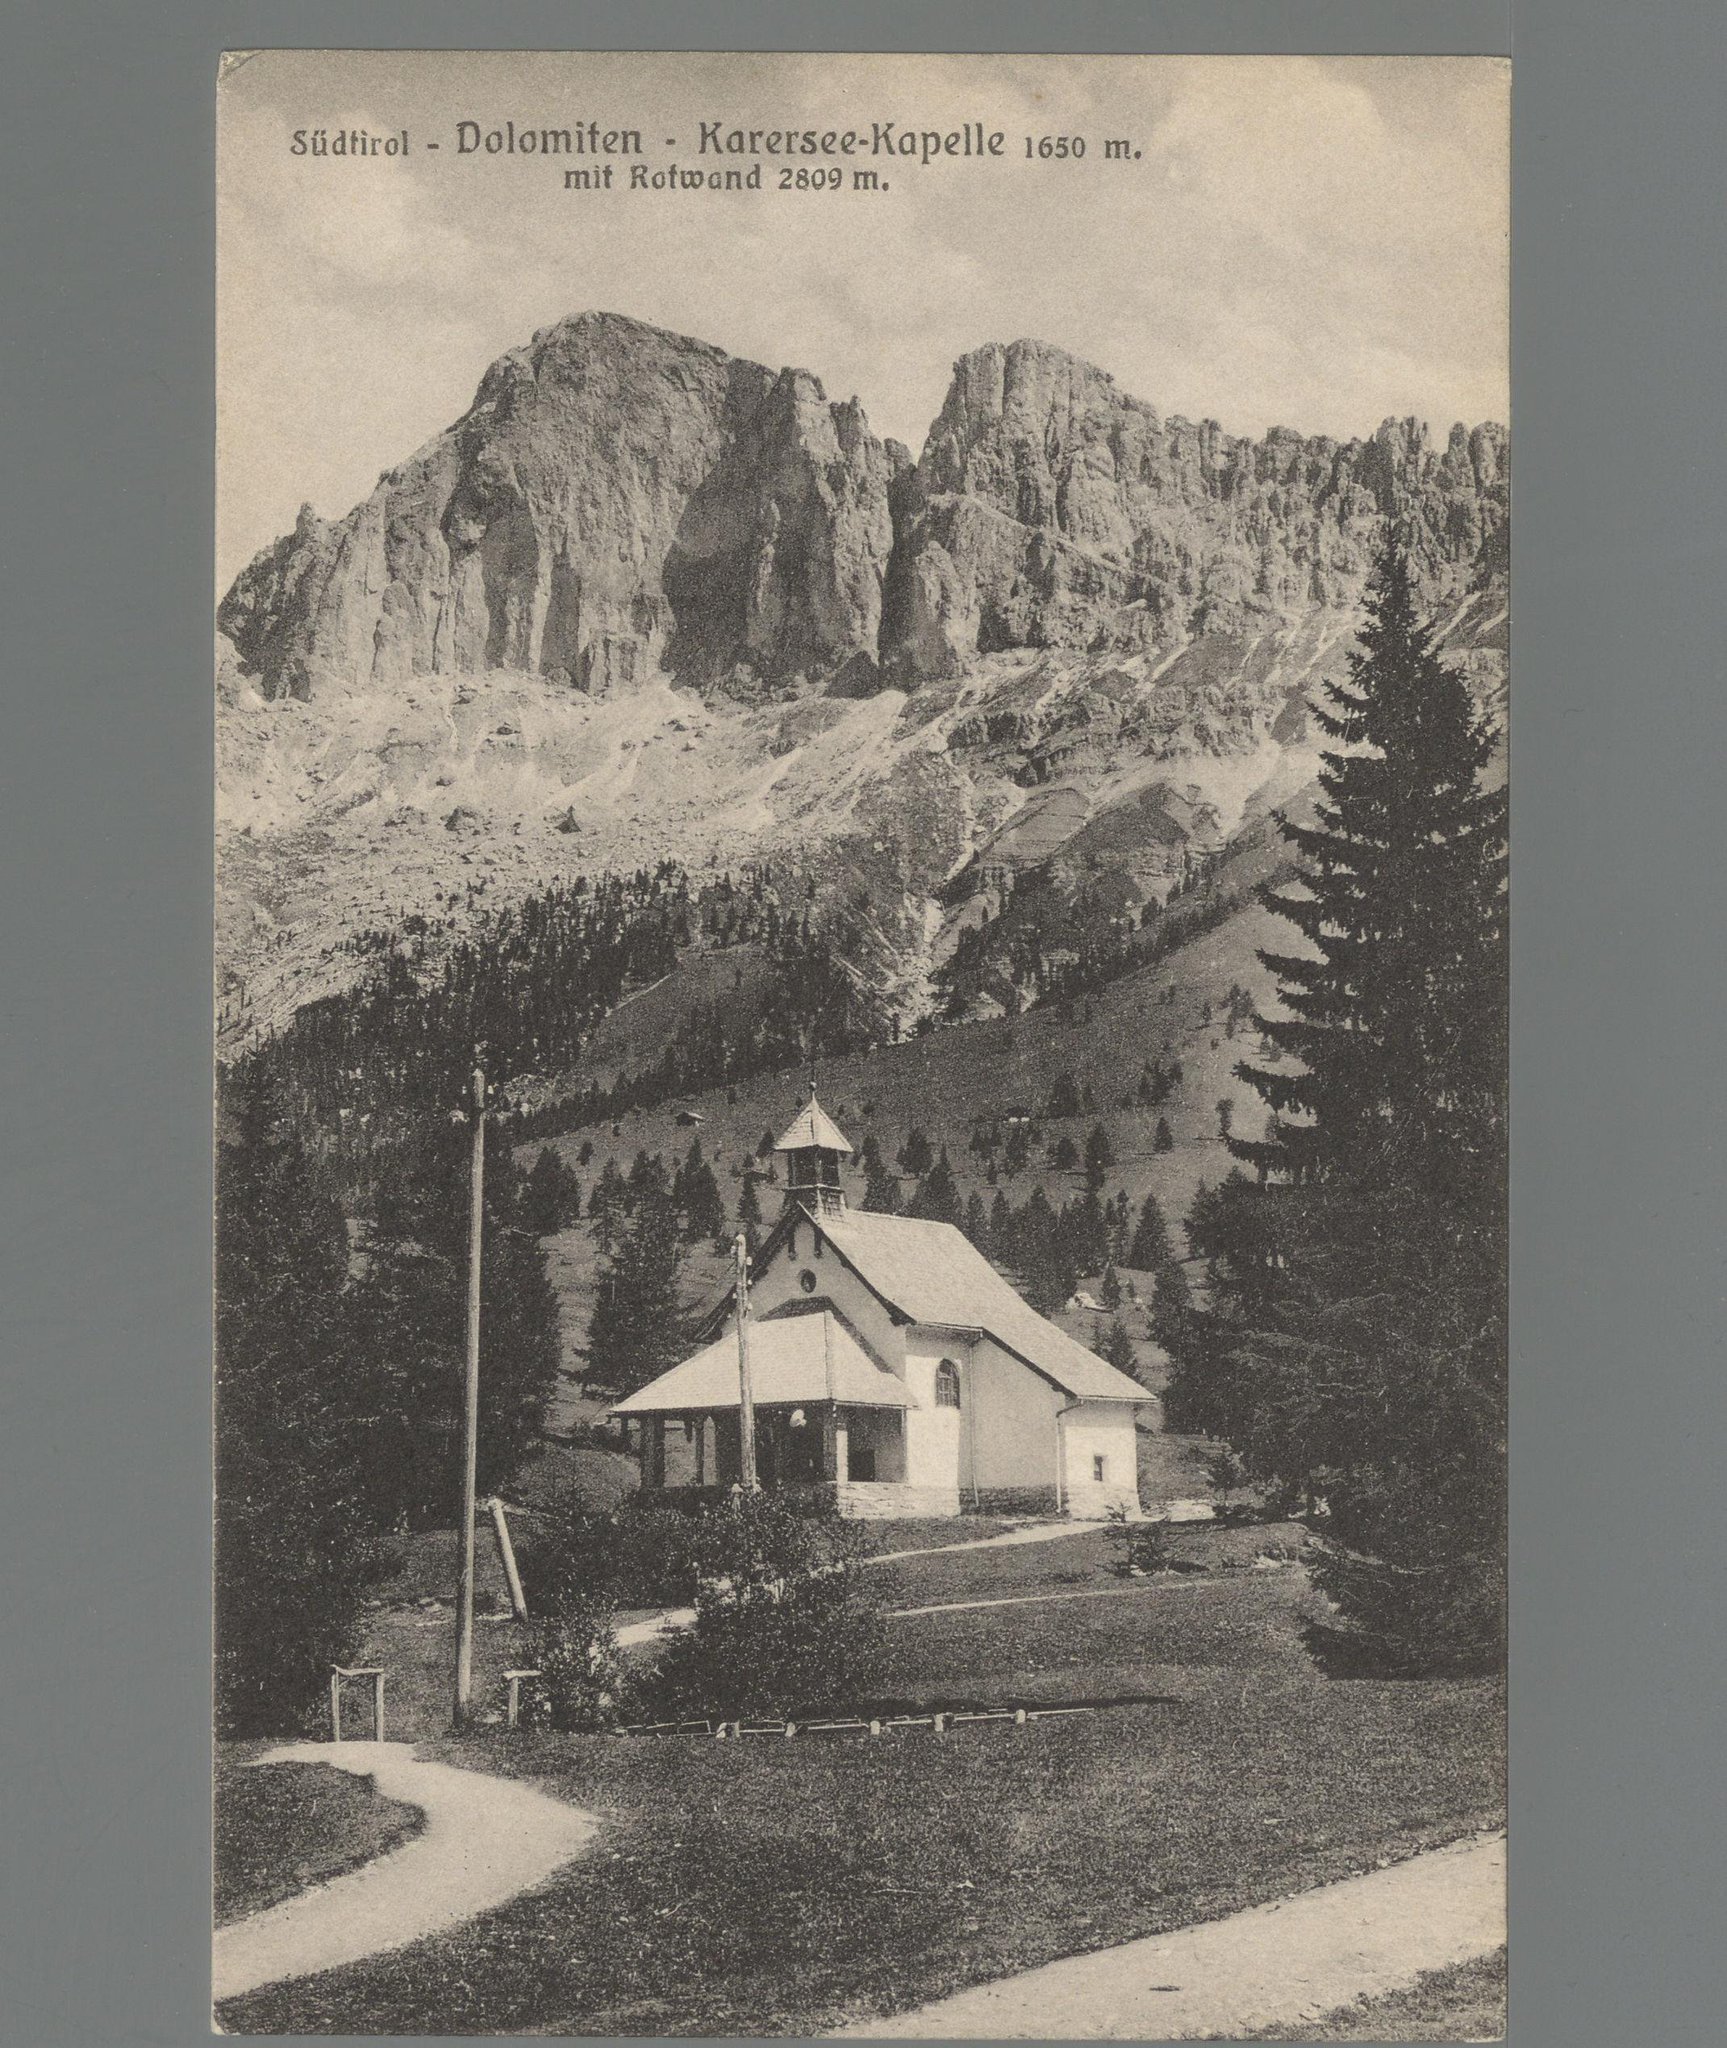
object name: ansichtkaart, prentbriefkaart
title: Südtirol. Dolomiten. Karersee-Kapelle, 1650m, mit Rotwand 2809 m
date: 1906-1930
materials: cardboard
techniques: photograph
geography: munich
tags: church (exterior), mountains